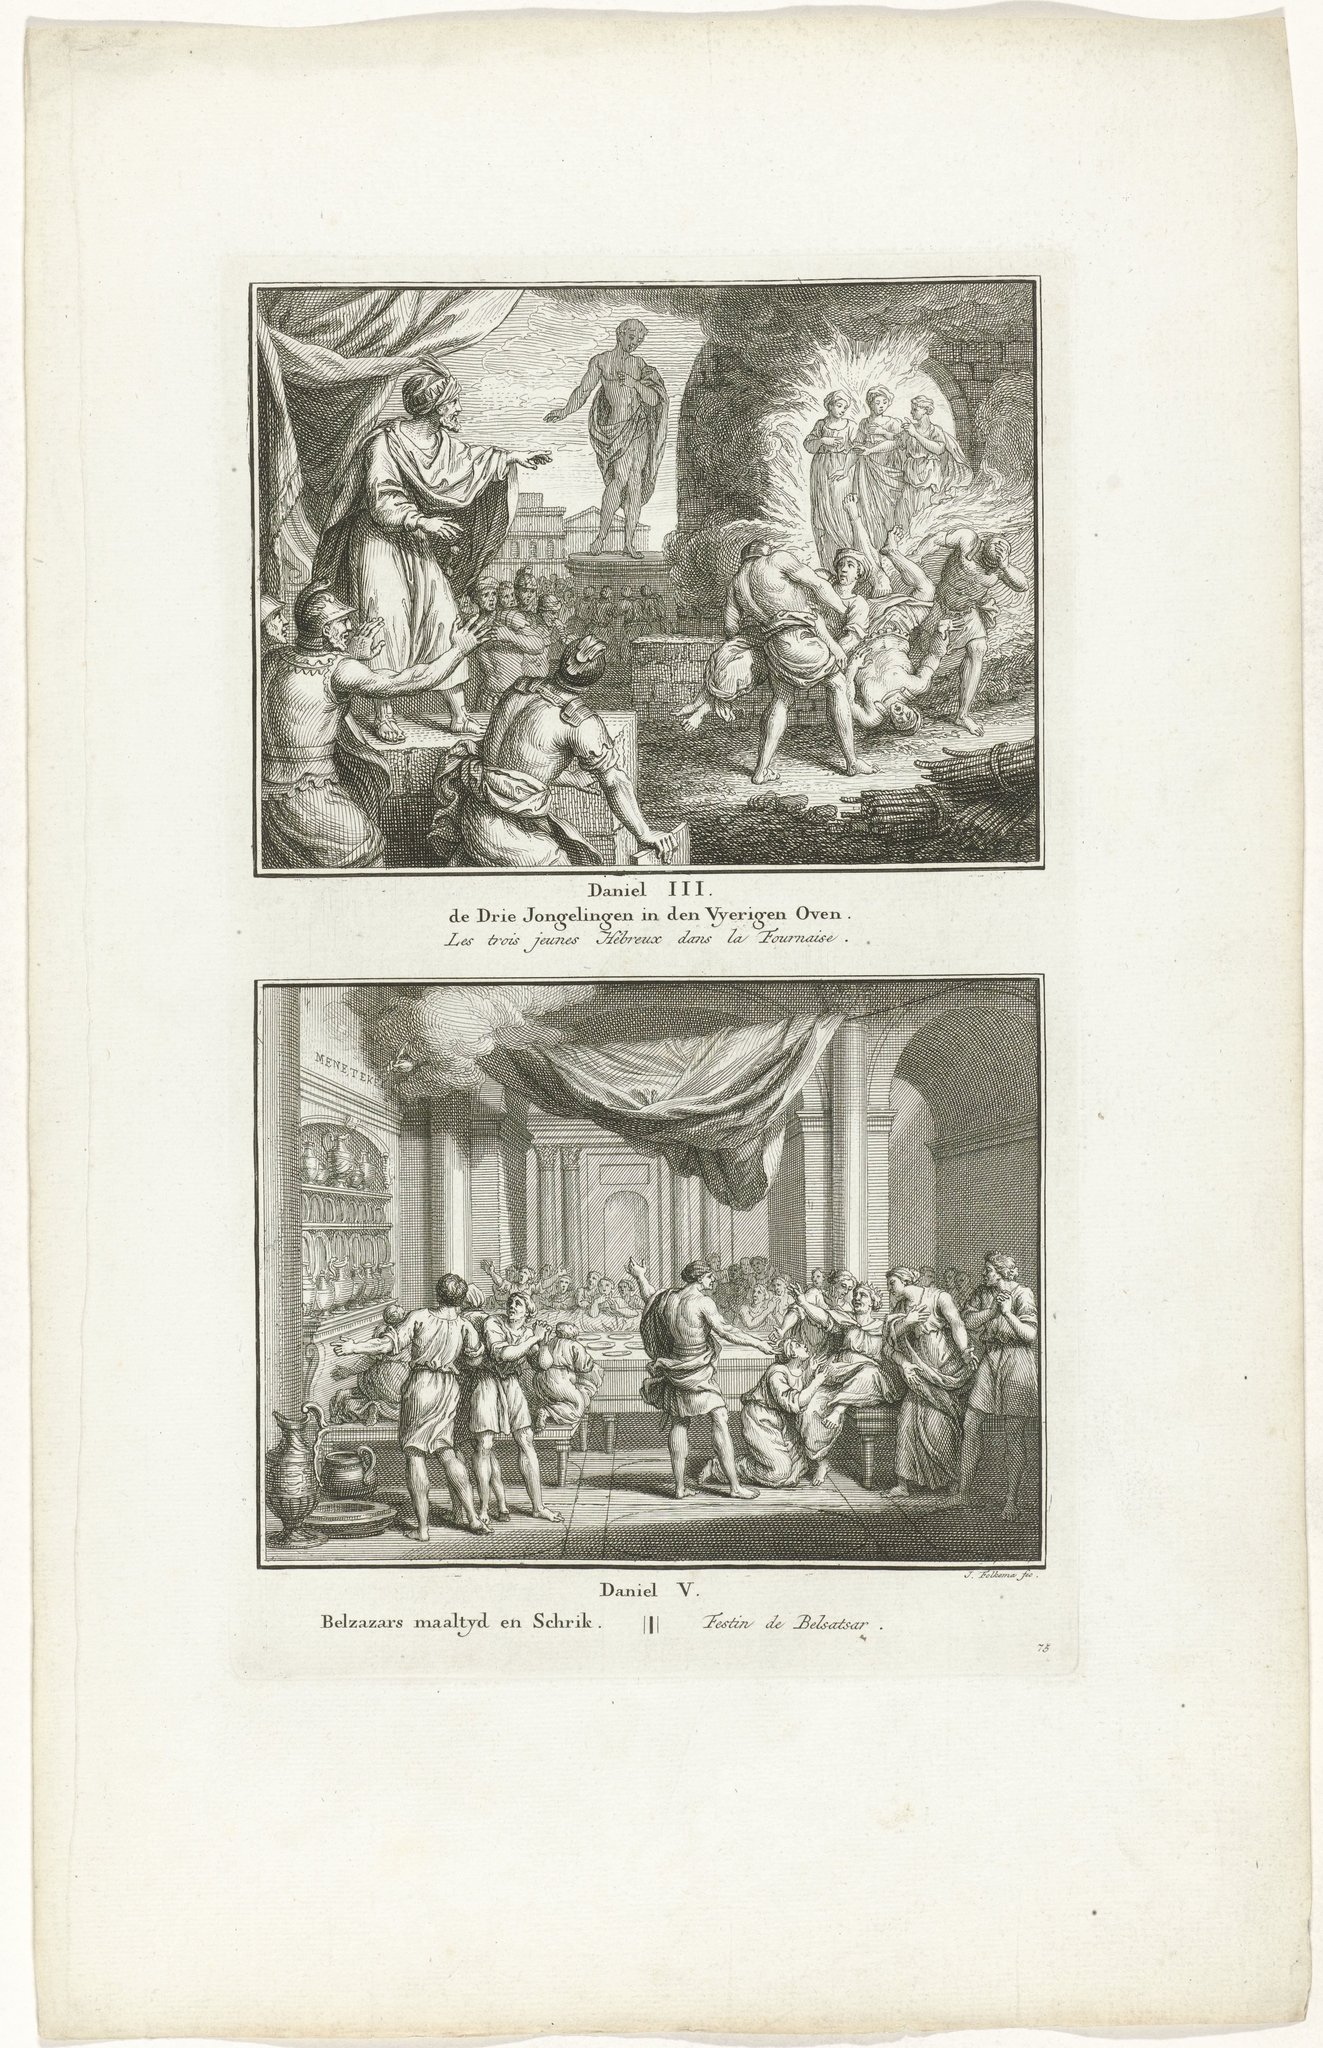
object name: print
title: Drie jongelingen in de brandende oven en het feestmaal van Belsassar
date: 1791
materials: paper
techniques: etching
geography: amsterdam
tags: the story of the three hebrews in the fiery furnace (daniel 3), during belshazzar's banquet a hand appears and writes on the wall (mene, mene, tekel and parsin (upharsin)); king belshazzar is frightened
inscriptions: collector's mark: Lugt 2233, collector's mark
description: Twee Bijbelse voorstellingen uit Dan. 3 en 5. Drie jongelingen worden in de brandende oven beschermd door God, en tijdens het feestmaal van Belsassar verschijnt een hand die een tekst op de muur schrijft. Twee voorstellingen van één plaat, elk voorzien van een titel in het Nederlands en Frans. Geheel rechtsonder genummerd: 75.